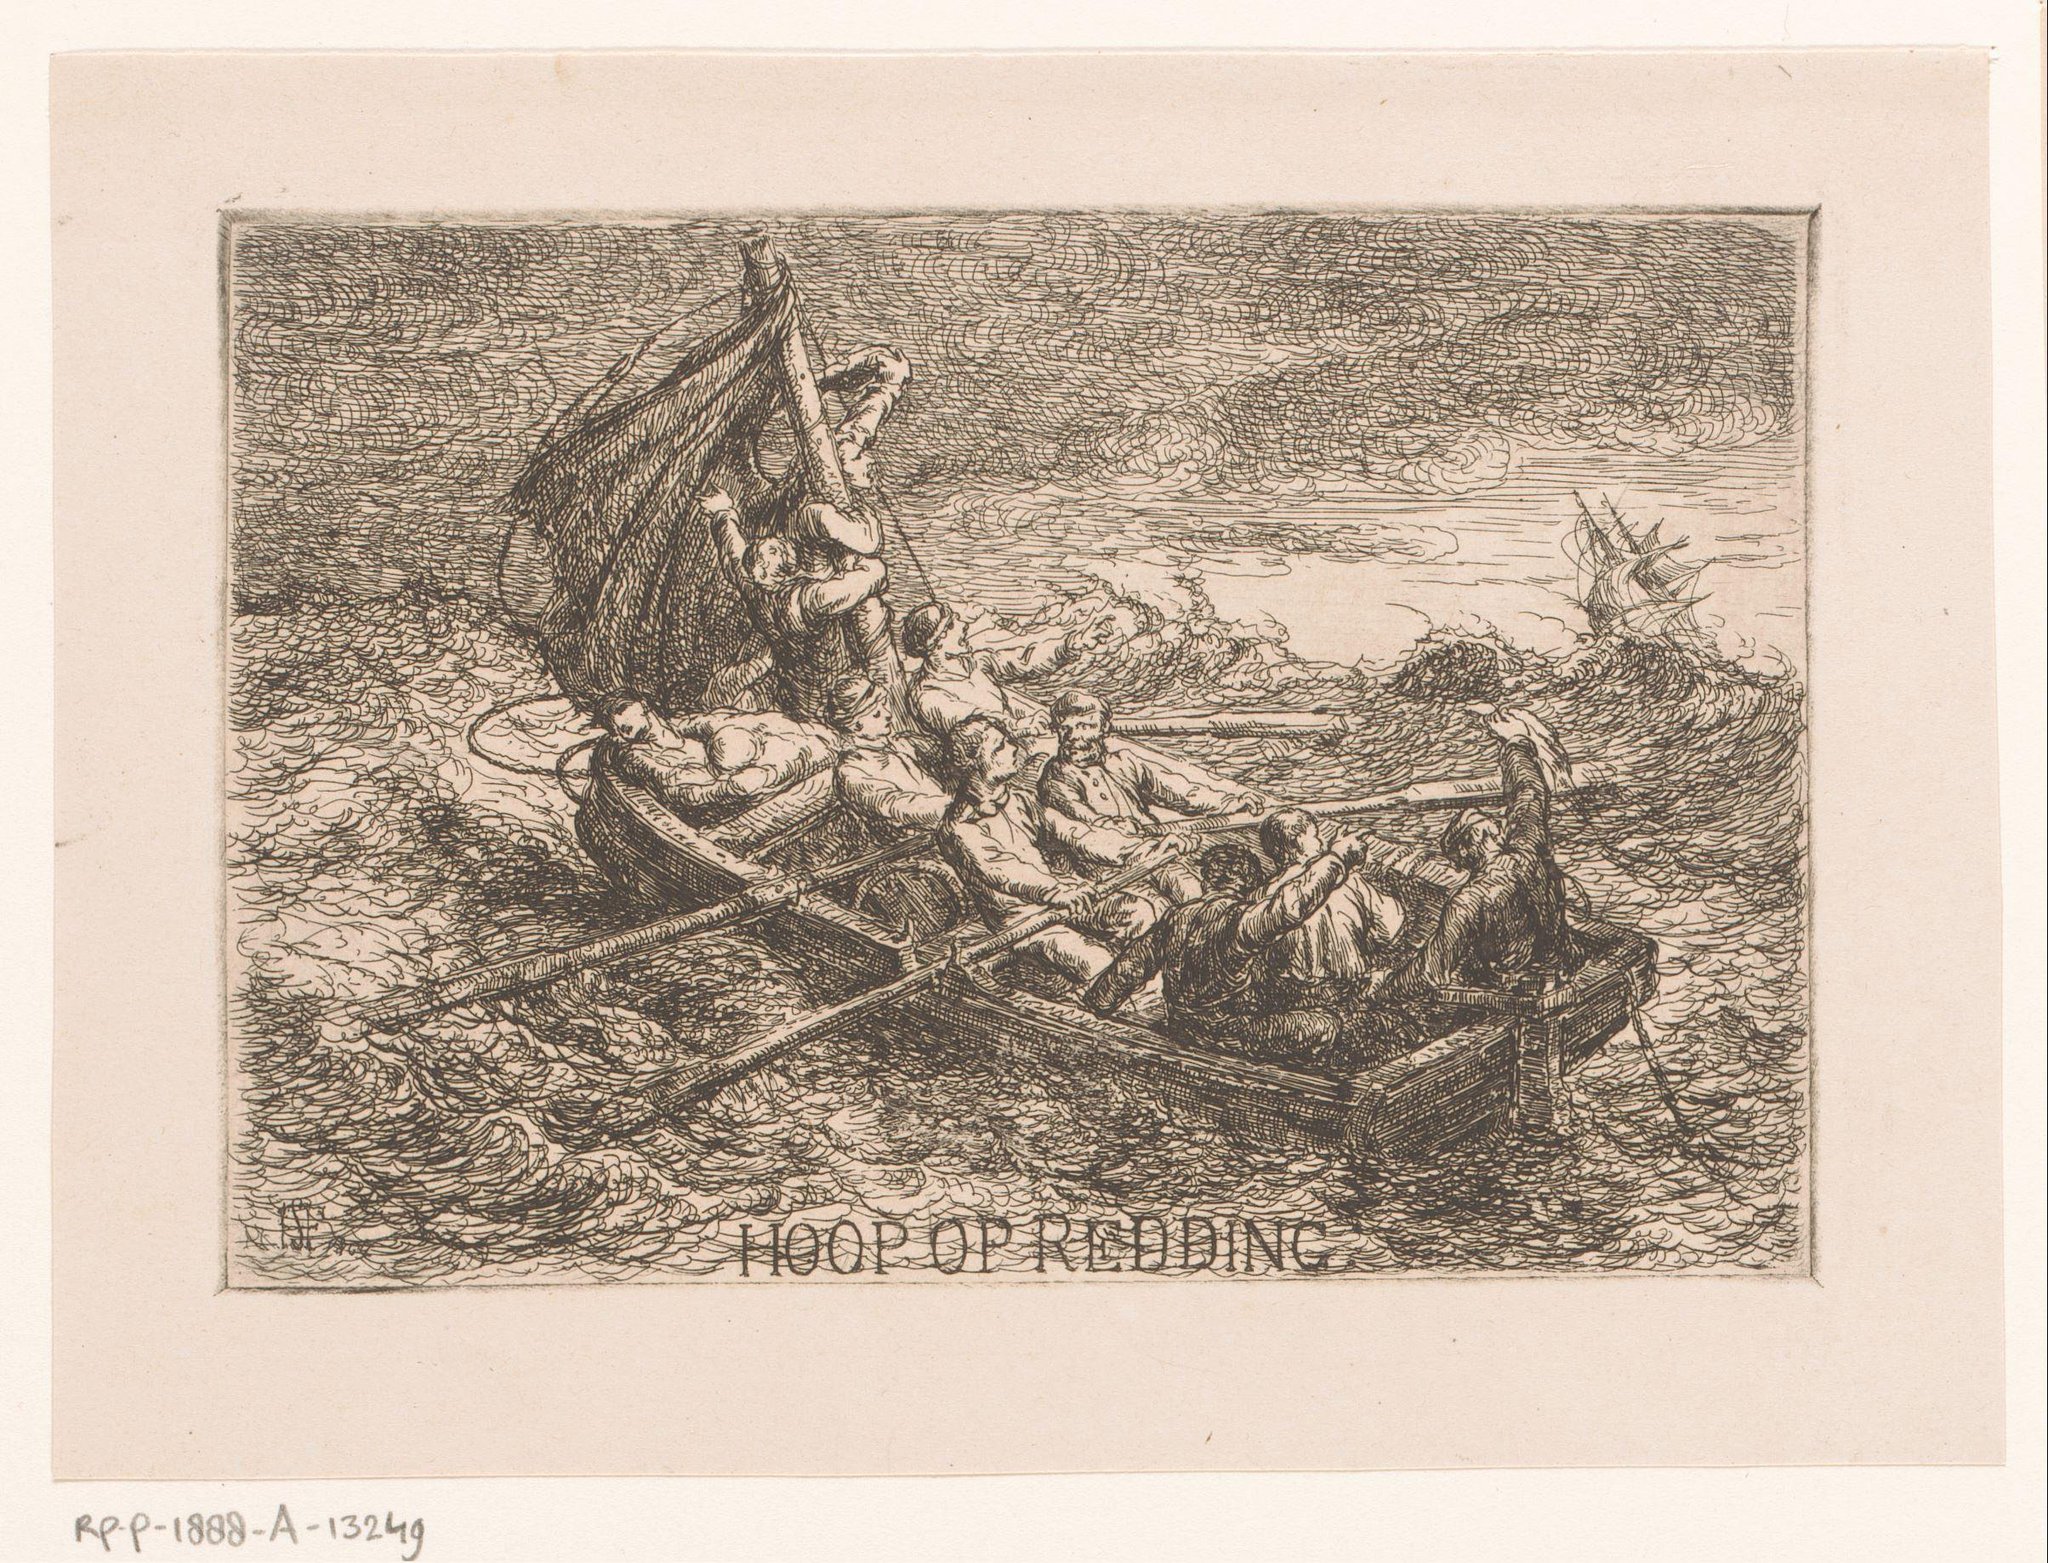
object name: print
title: Roeiboot in nood op zee ziet een schip in de verte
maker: henri françois schaefels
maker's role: print maker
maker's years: 1827-1904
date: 1864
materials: paper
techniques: etching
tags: sailing-ship, sailing-boat, saving an endangered fellow man, rowing-boat, canoe, etc.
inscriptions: collector's mark: Lugt 2228